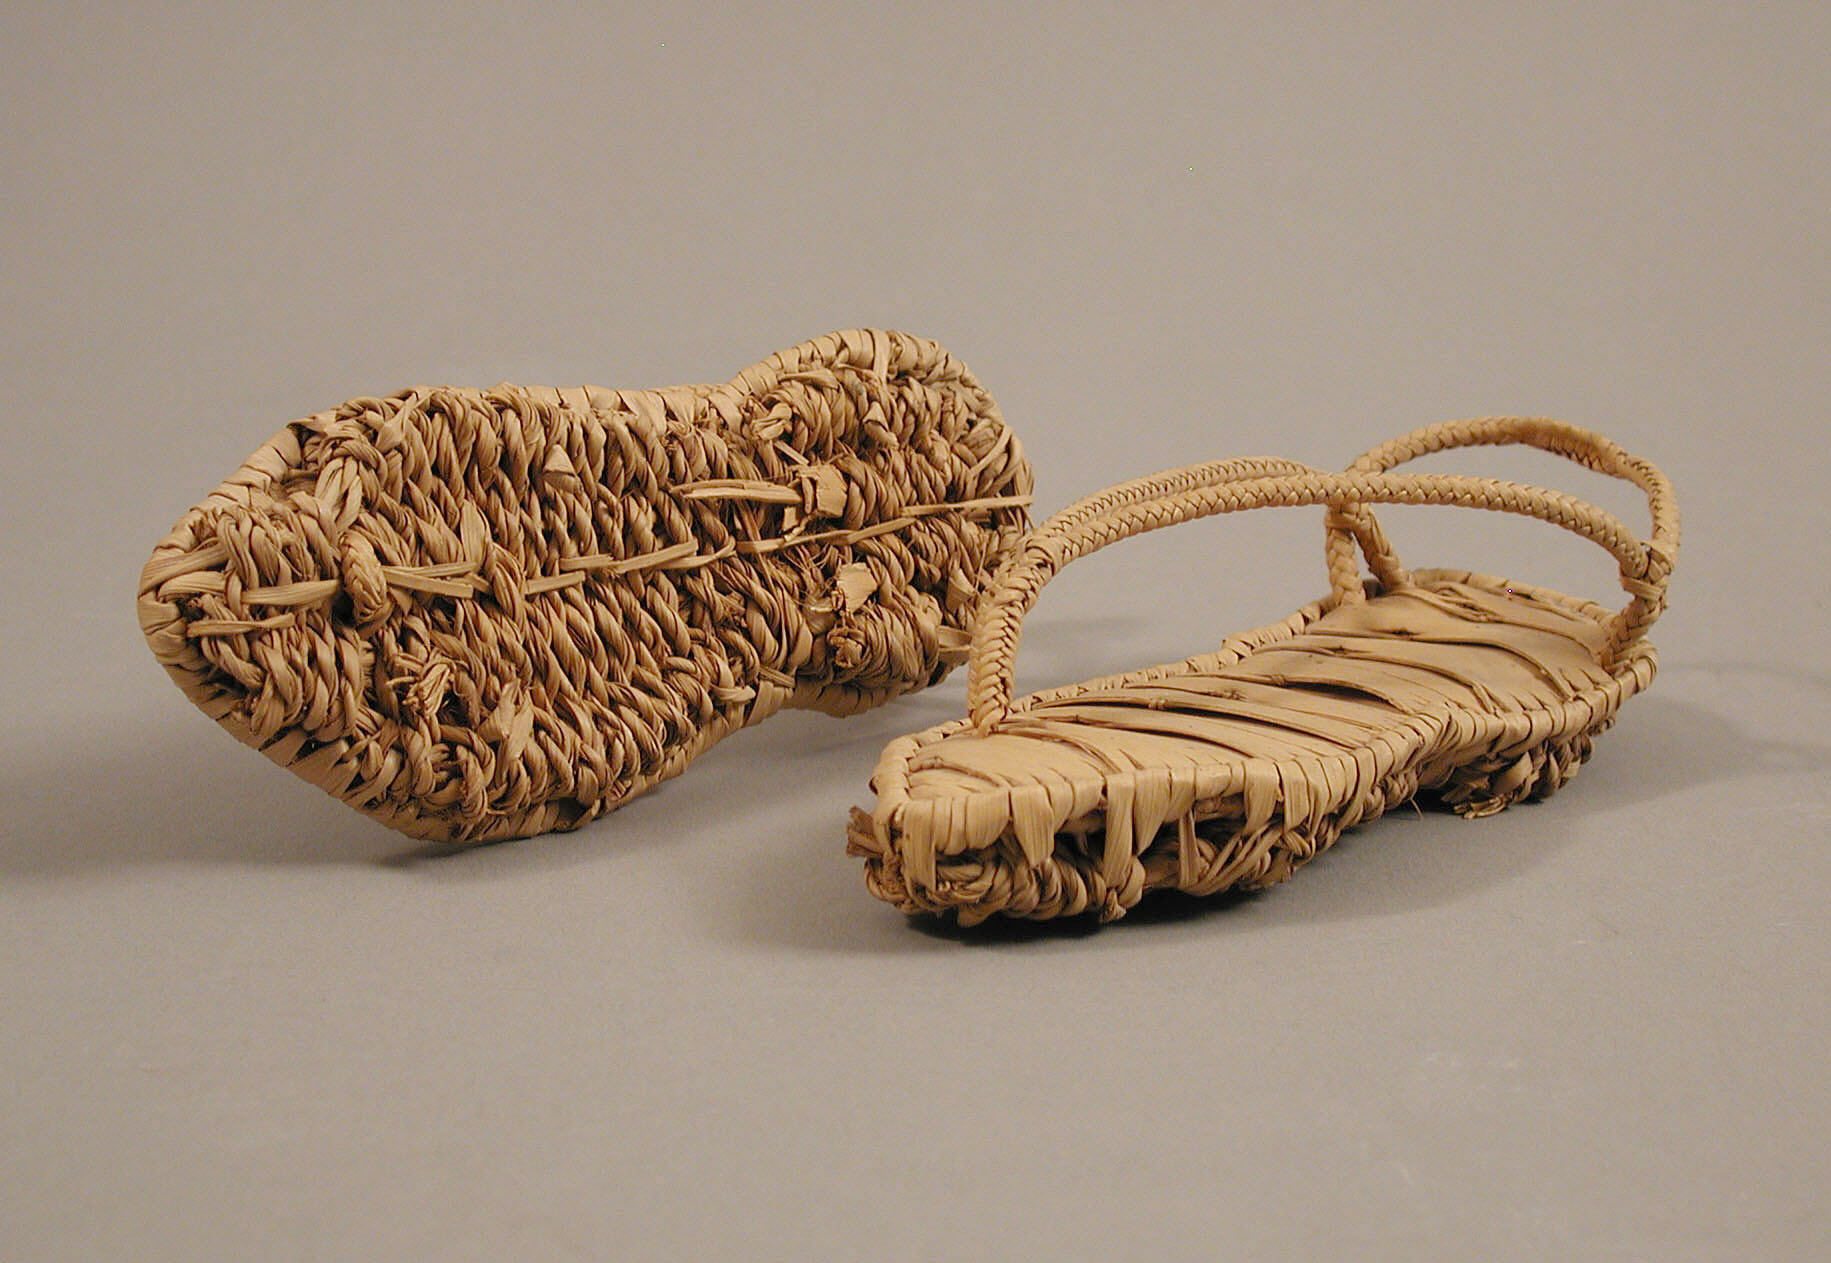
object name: sandal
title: Pair of Sandals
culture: coptic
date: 301-700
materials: leaf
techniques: weave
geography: egypt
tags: footwear